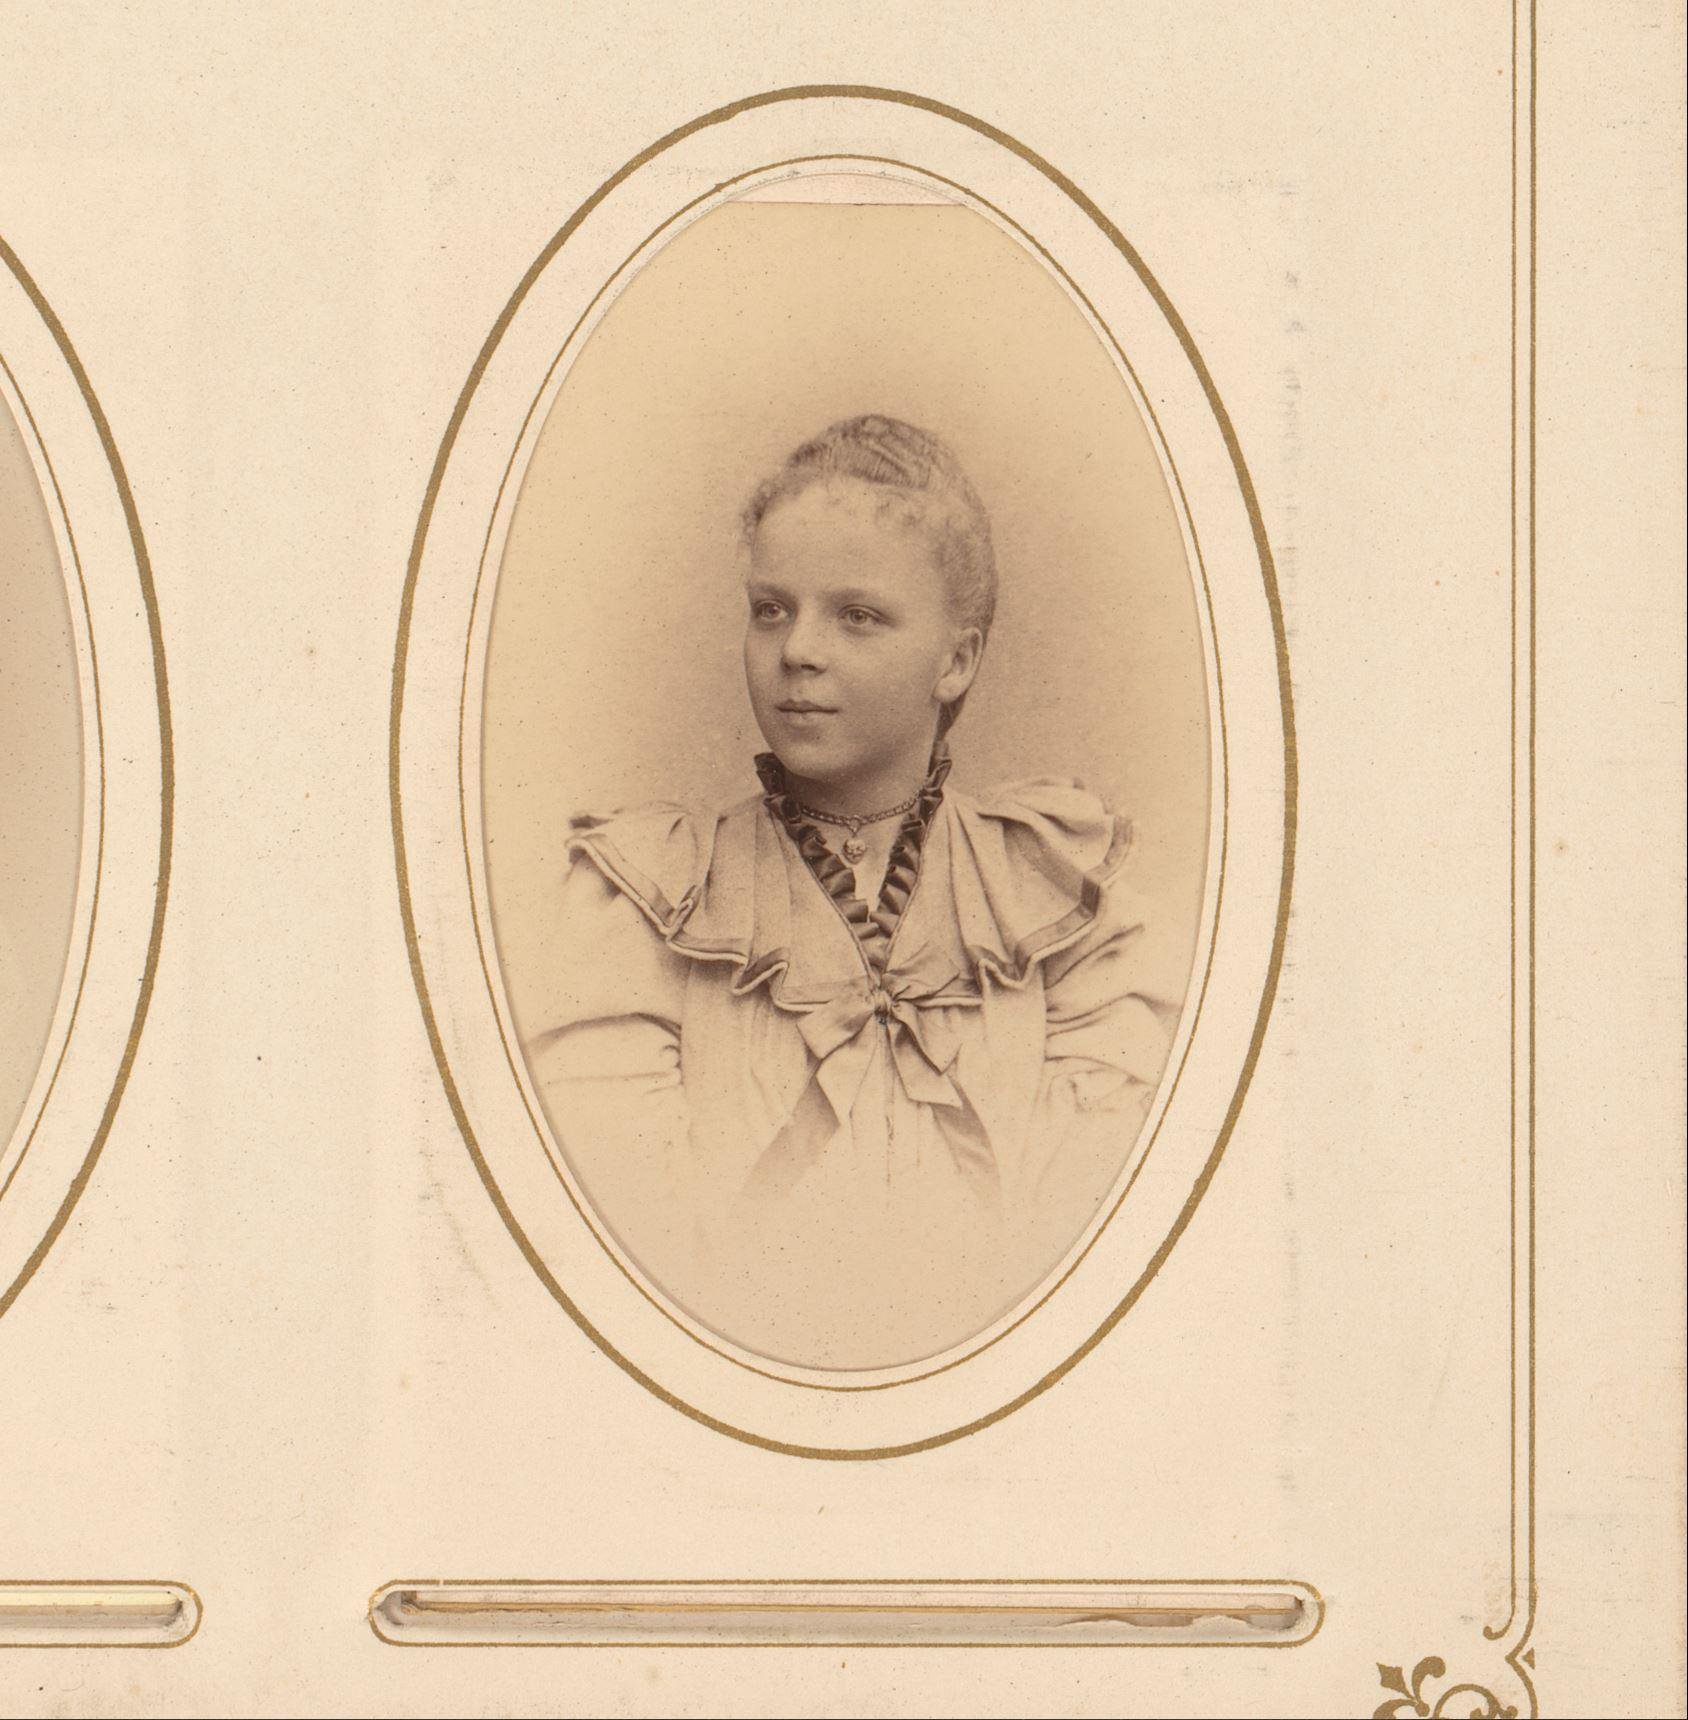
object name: carte de visite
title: Portret van een jonge vrouw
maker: jean baptiste feilner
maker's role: fotograaf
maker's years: 1844-1912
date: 1875-1899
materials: cardboard, photographic support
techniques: albumen print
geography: germany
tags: adolescent, young woman, maiden, historical persons - bb - woman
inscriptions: inscription: ‘Jean Baptiste Feilner/ Hofphotograph Sr. Königl. Hoheit d. Erbgrofsherzogs v. Oldenburg/ HANNOVER/ Georgstr. 25./ BREMEN/ Richtweg 6b. Parterre./ OLDENBURG/ Rosenstr. 29./ BORKUM./ BRAUNSCHWEIG/ südliche Wilhelmstr. 88./ EMDEN.’, annotation: ‘Bertha Sch[ät]ze/ Mutter [...]’